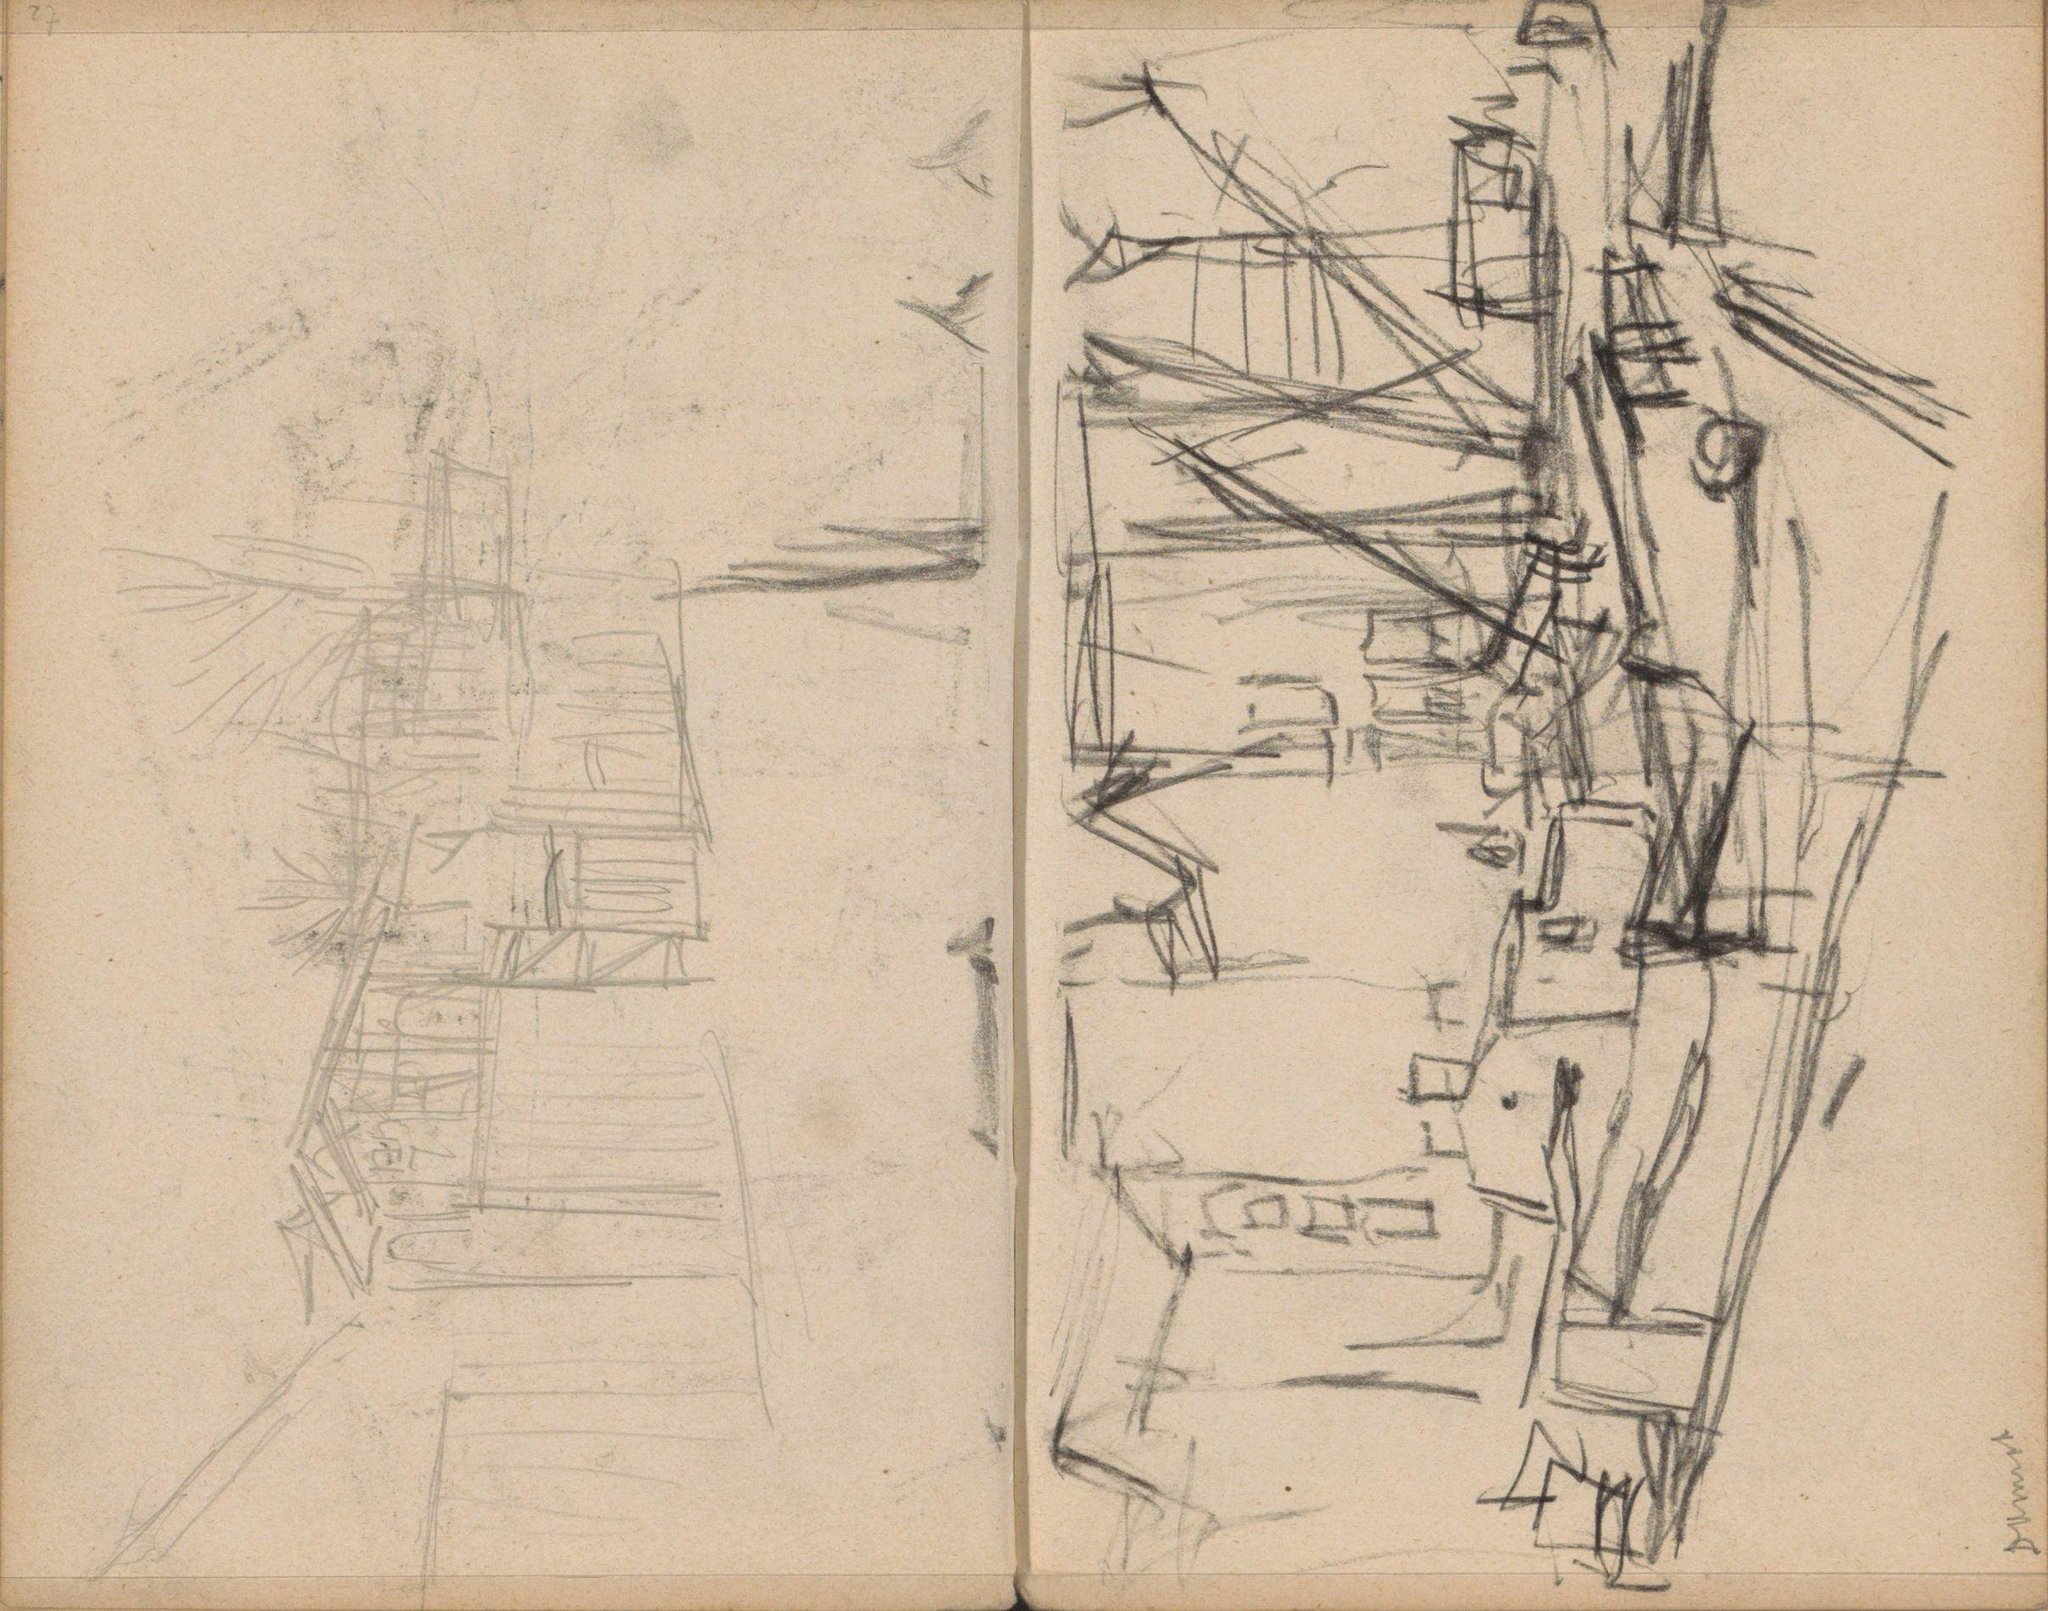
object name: sketchbook leaf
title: Twee gezicht in Amsterdam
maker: george hendrik breitner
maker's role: draughtsman, painter, print maker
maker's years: 1857-1923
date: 1906-1923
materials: chalk, paper, pencil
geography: amsterdam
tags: urban housing, ships (in general), canals, waters (in city), street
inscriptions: annotation: ‘Damrak’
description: Boven mogelijk een gezicht op huizen in de De Clercqstraat te Amsterdam. Onder een gezicht op boten aan het Damrak. Pagina 27 en pagina 28 uit een schetsboek met 46 bladen vervaardigd in Amsterdam en Haarlem.